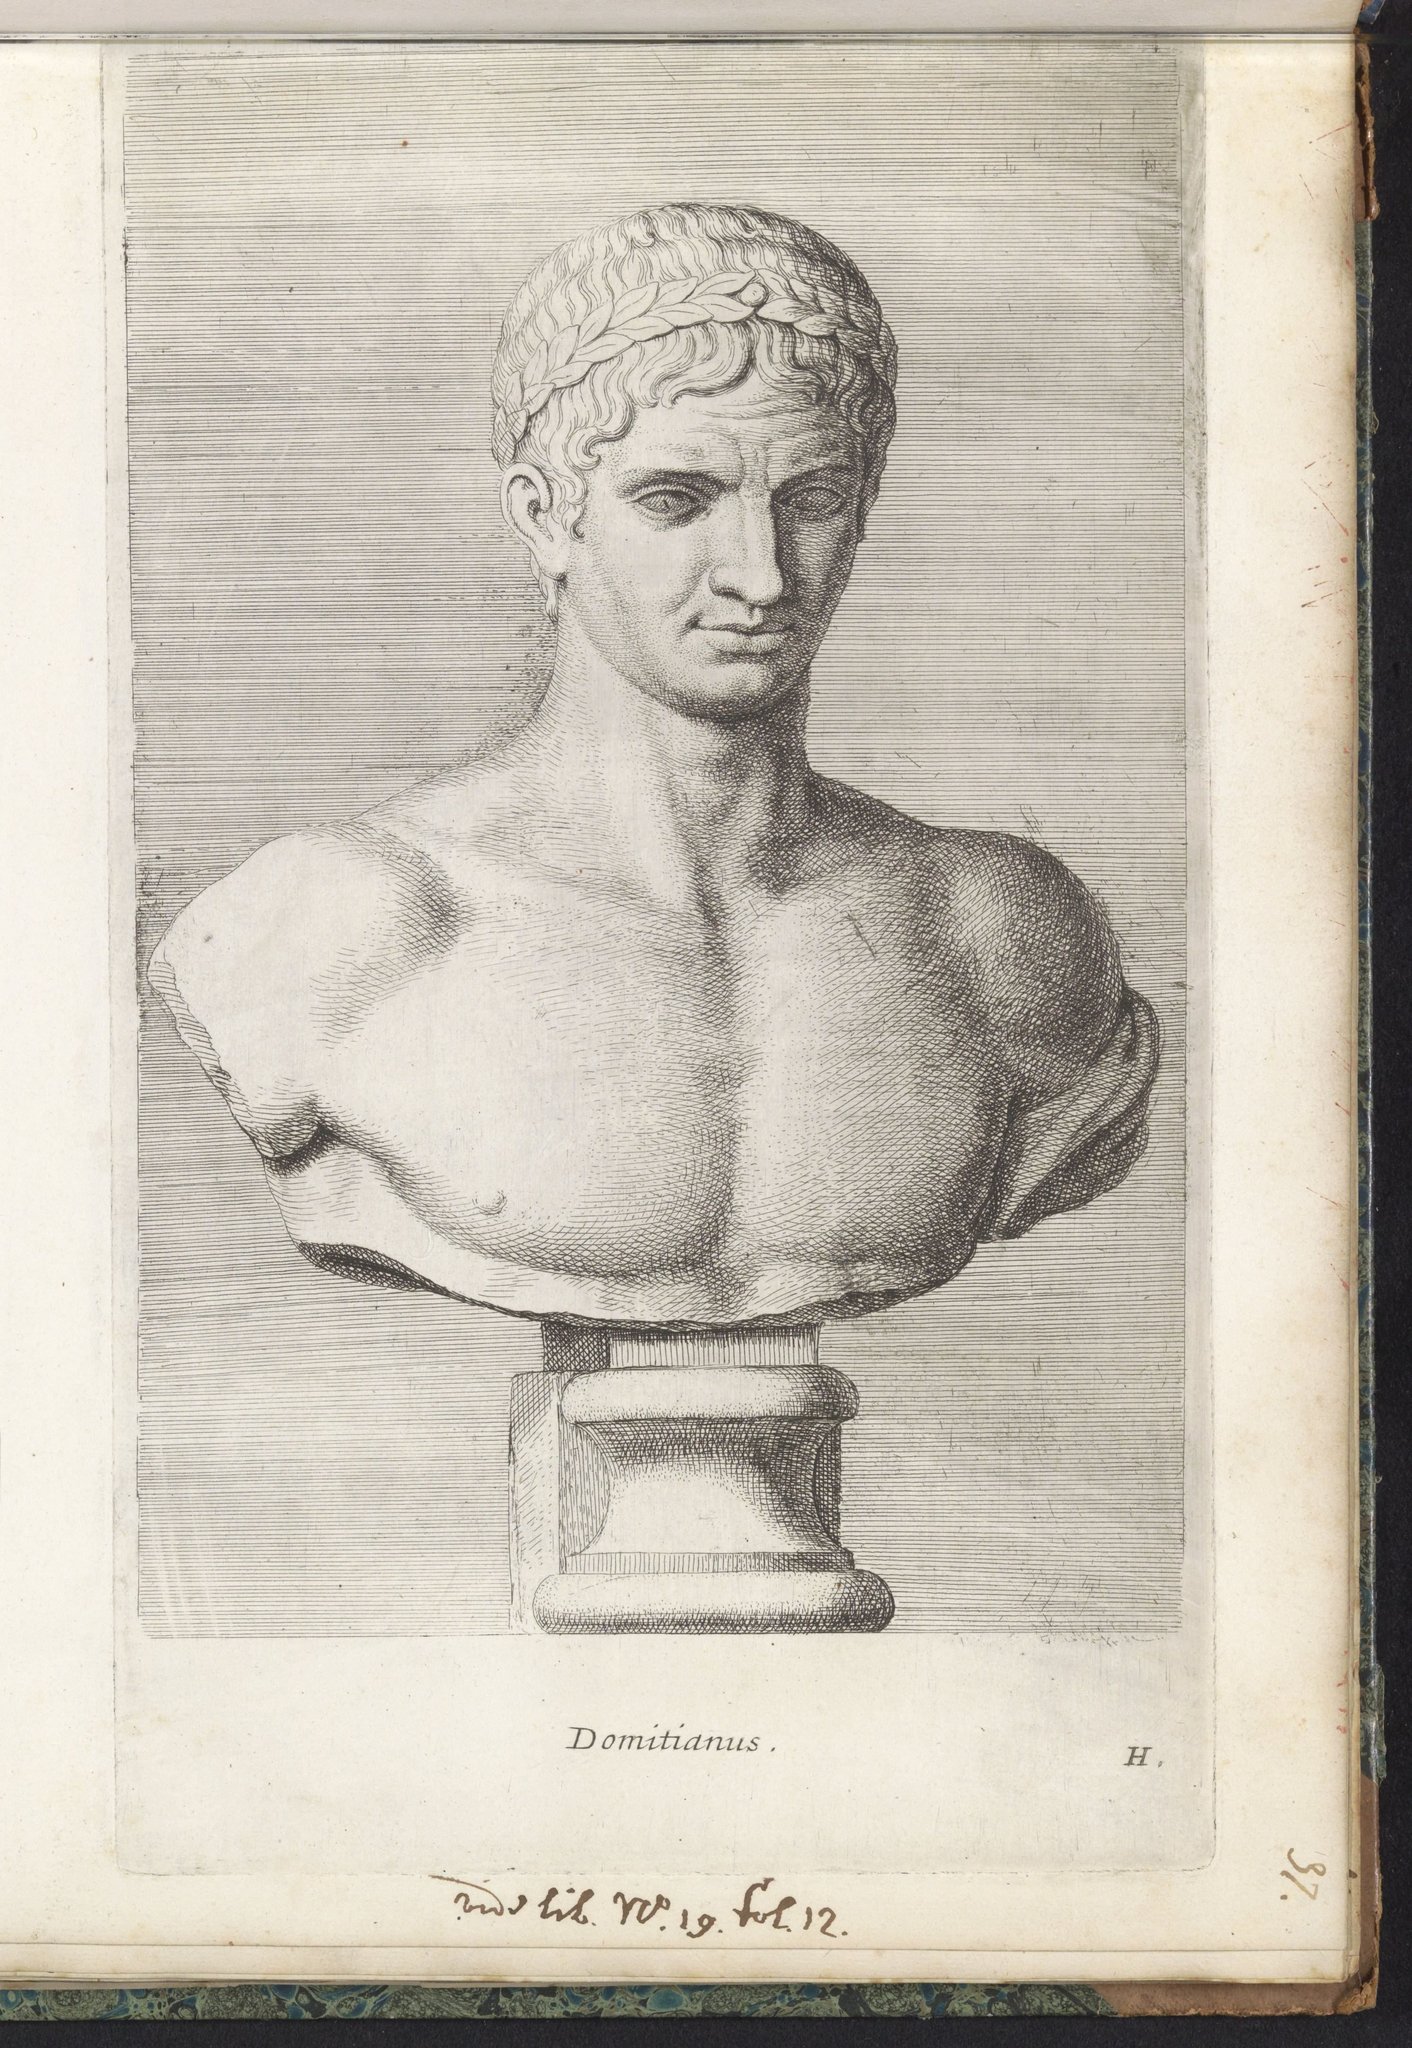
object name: album leaf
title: Domitianus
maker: hubert quellinus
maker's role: print maker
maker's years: 1619-1687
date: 1646-1670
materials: paper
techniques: engraving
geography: antwerp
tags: piece of sculpture, reproduction of a piece of sculpture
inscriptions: inscription: ‘Vide lib. No. 19 fol. 12’, number: ‘37’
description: Klassieke buste van een jonge man met ontbloot bovenlijf en lauwerkrans om het hoofd. Rechtsonder: H. De prent maakt deel uit van een album met een serie prenten naar de sculpturen in de verzameling van Gerard Reynst.